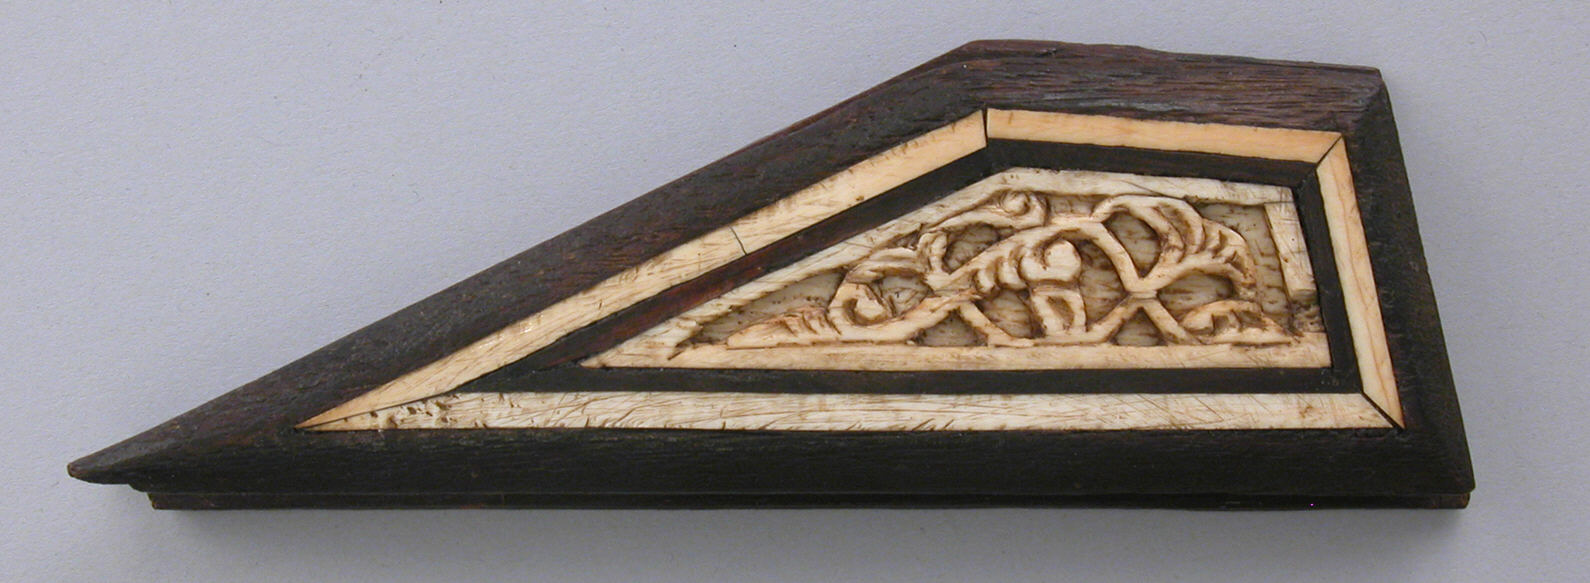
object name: panel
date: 1201-1400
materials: ivory, wood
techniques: carving, inlay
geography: egypt